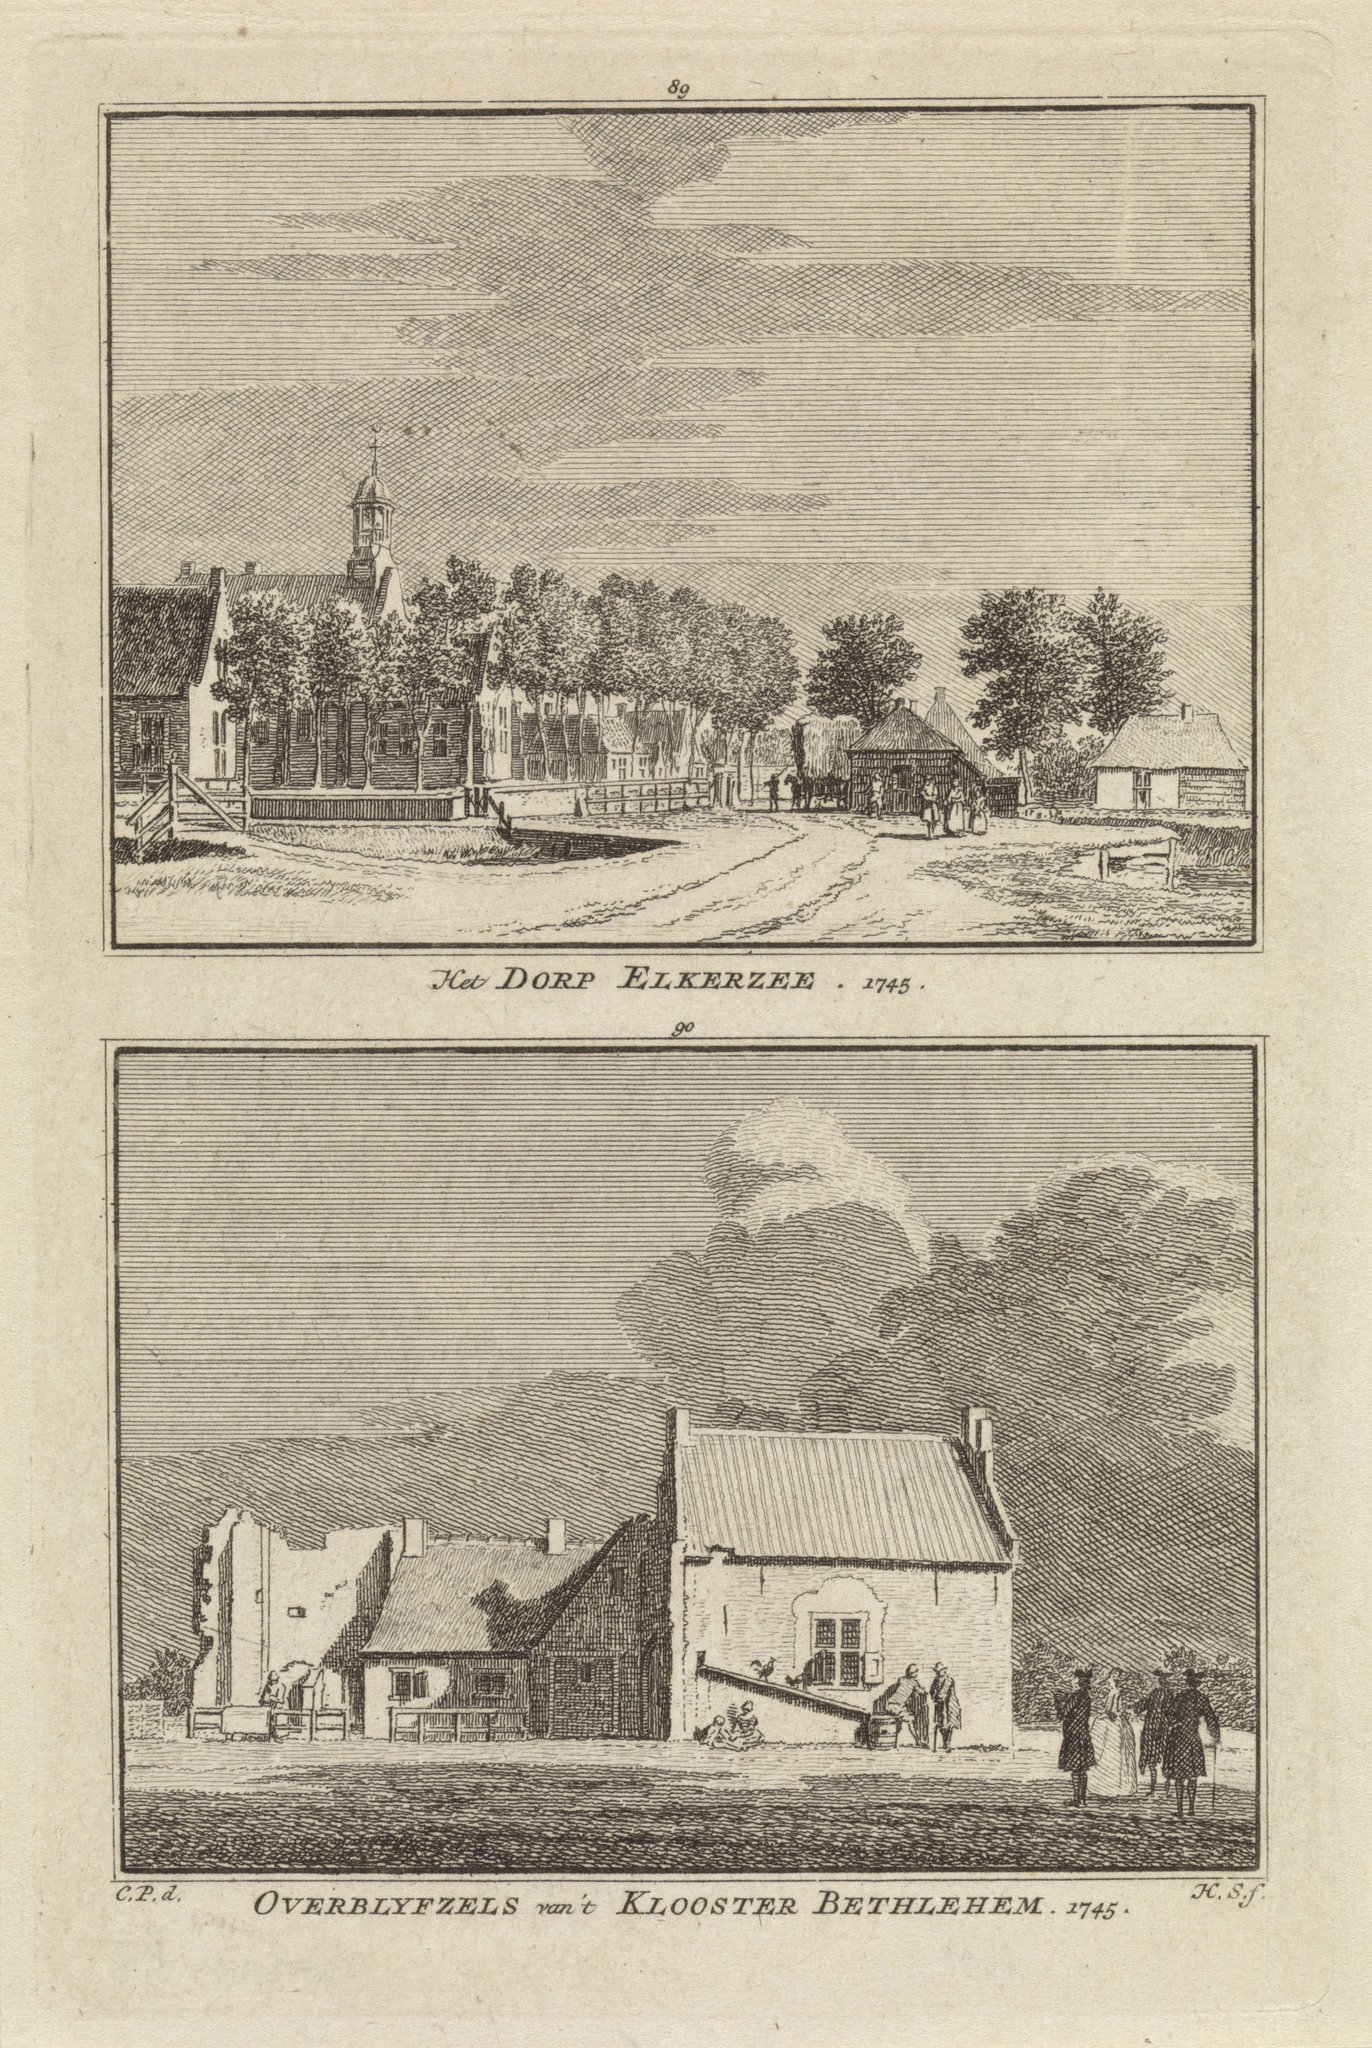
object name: book illustration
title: Het dorp Elkerzee, 1745/ Overblyfzels van 't klooster Bethlehem, 1745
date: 1754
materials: paper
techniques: etching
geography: haarlem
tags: ruin of church, monastery, etc., public road in village, elkerzee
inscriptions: collector's mark: Lugt 2228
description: Prent gebruikt in: Het verheerlykt Nederland of kabinet van hedendaagsche gezigten van steden, dorpen, sloten ... en andere voornaame stad- en landgebouwen, in en omtrent alle de byzondere Vereenigde Nederlandsche Provinciën : gedurende de laatste jaaren door vermaarden kunsttekenaren na het leven getekent en ... in 't koper gebragt ... dienende tot opheldering der beschryvinge van den Tegenwoordigen Staat der Vereenigde Nederlanden. Deel V, 1754. Amsterdam: Isaac Tirion, 1745-1774.